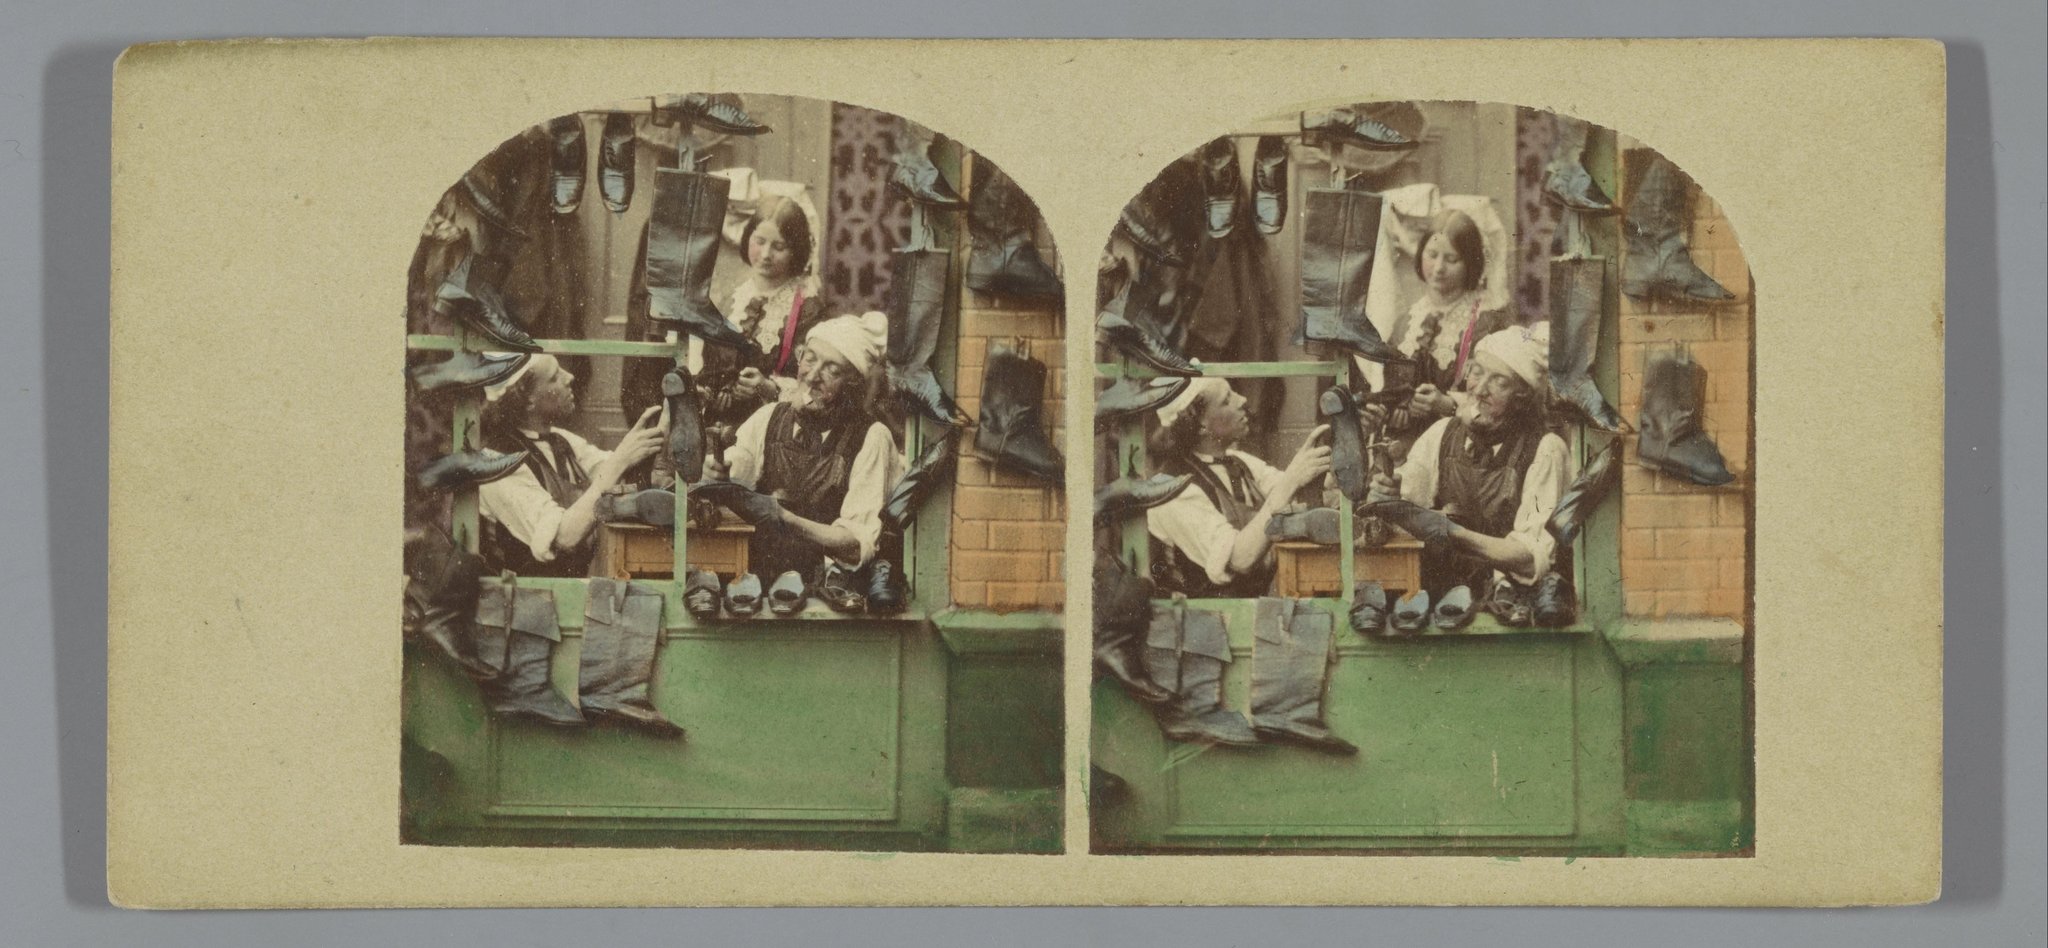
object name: stereograph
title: Drie schoenlappers aan het werk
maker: Anonymous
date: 1852-1863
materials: cardboard, paper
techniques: albumen print, hand coloring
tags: adult woman, shoe-maker, cobbler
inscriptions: stamp: ‘S. A. MEERBURG/ LEIJDEN’, inscription: ‘J. C. MEERBURG,’